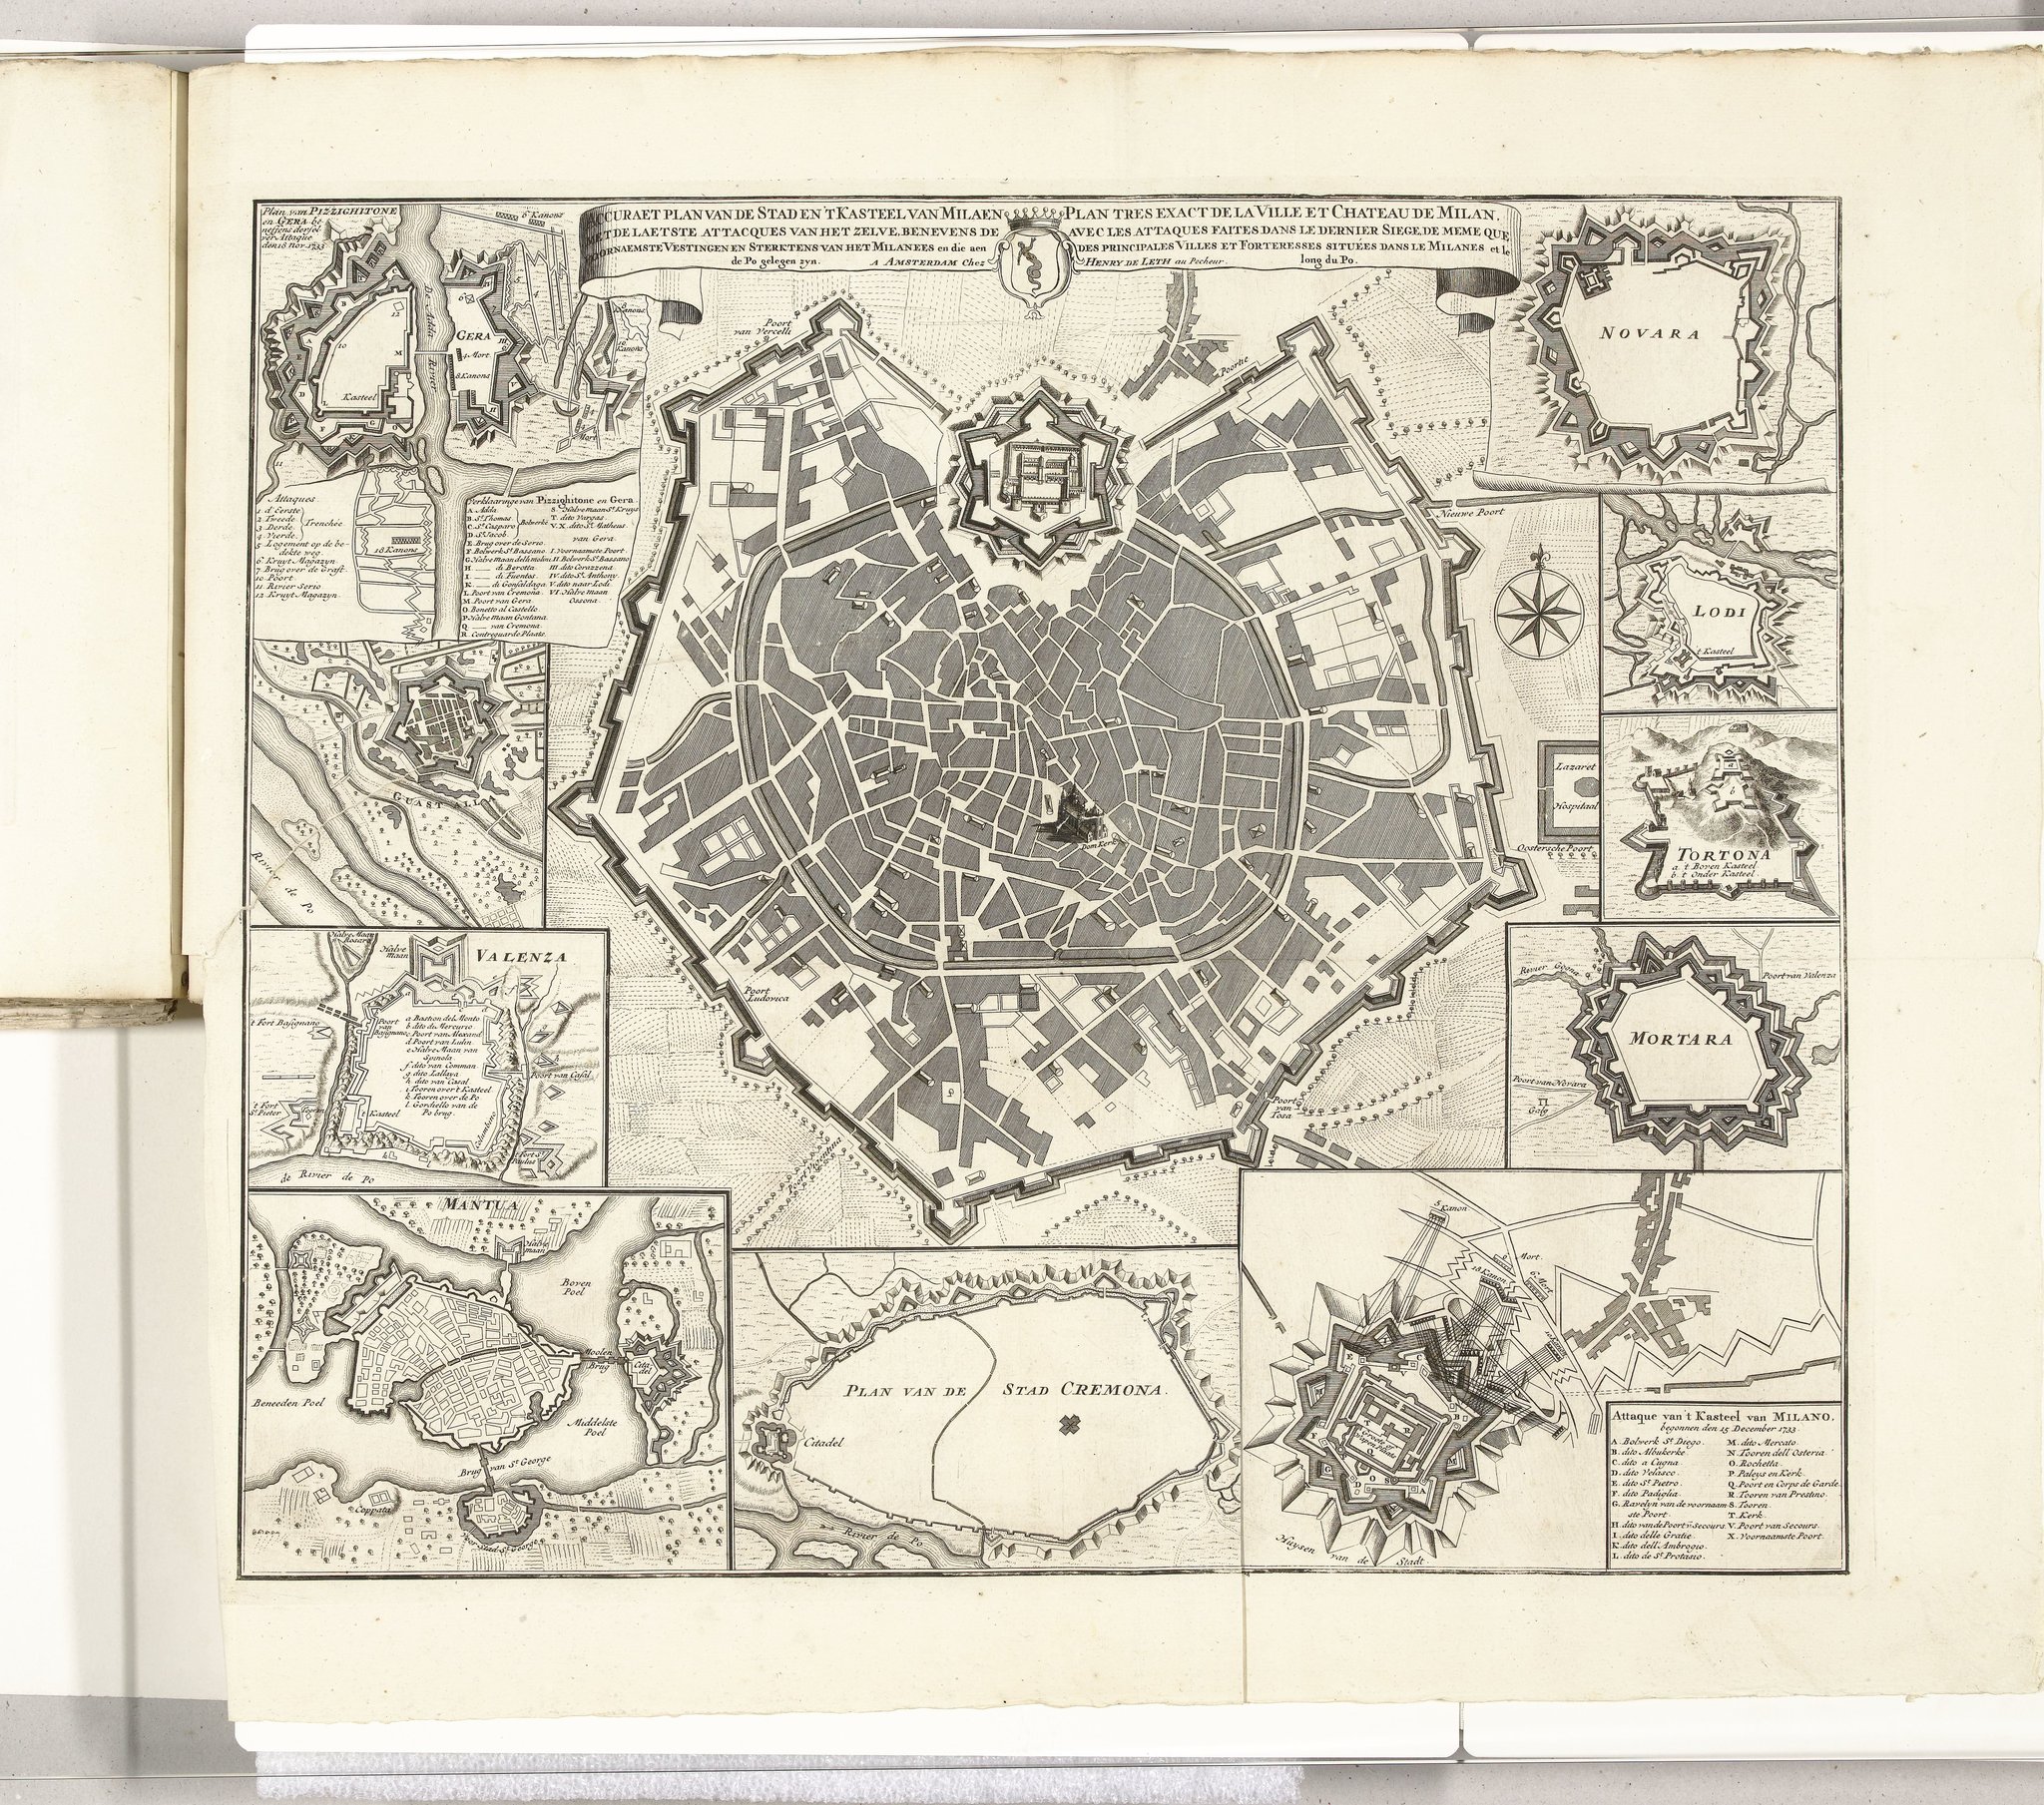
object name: map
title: Accuraet plan van de stad en 't kasteel van Milaen / Plan tres exact de la ville et Chateau de Milan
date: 1733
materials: paper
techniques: etching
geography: amsterdam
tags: fortress, maps of cities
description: Grote plattegrond van de versterkingen om de stad Milaan. Om de centrale voorstelling staan tien kleinere plattegronden van andere steden (Mantua, Cremona) en vestingen. Twee van deze scènes tonen belegeringen van Milaan (15 december 1733) en van Pizzighettone - Gera (18 november 1733). Ongenummerde plaat [nr. 120A] in het prentwerk bestaande in totaal uit 276 genummerde platen van vermaarde sterke steden en vestingen in het kader van de Spaanse Successieoorlog. Voor het merendeel zijn deze platen gekopieerd naar de anonieme Franse platen: in Les forces de l'Europe en in: Le theatre de la guerre, dans les Pays-Bas, beide oorspronkelijk uitgegeven door Nicolas de Fer te Parijs (1693-1697) in het kader van de Negenjarige Oorlog. Titels in het Nederlands en Frans, de opschriften in de plaat in het Nederlands. Later toegevoegd aan het album (?).